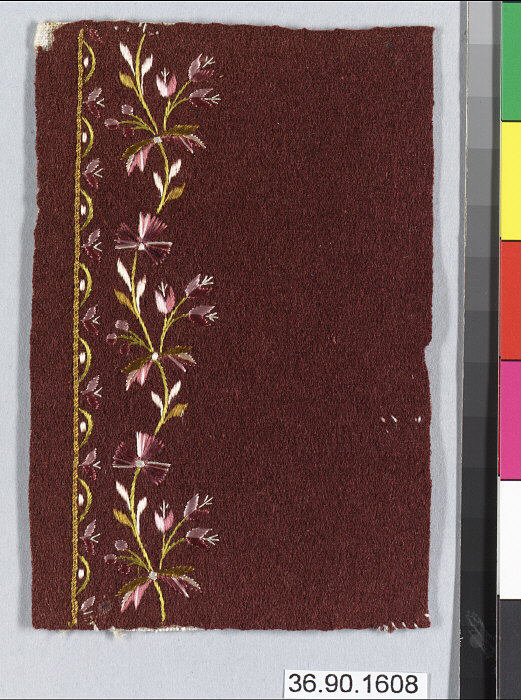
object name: sample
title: Embroidery sample for a man’s suit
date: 1785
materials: silk, wool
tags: flowers